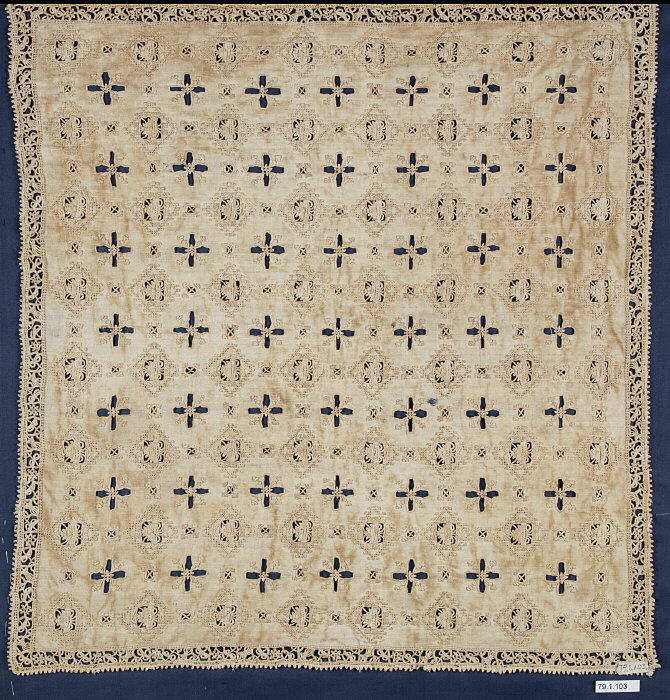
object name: cover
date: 1501-1600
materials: linen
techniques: embroidery